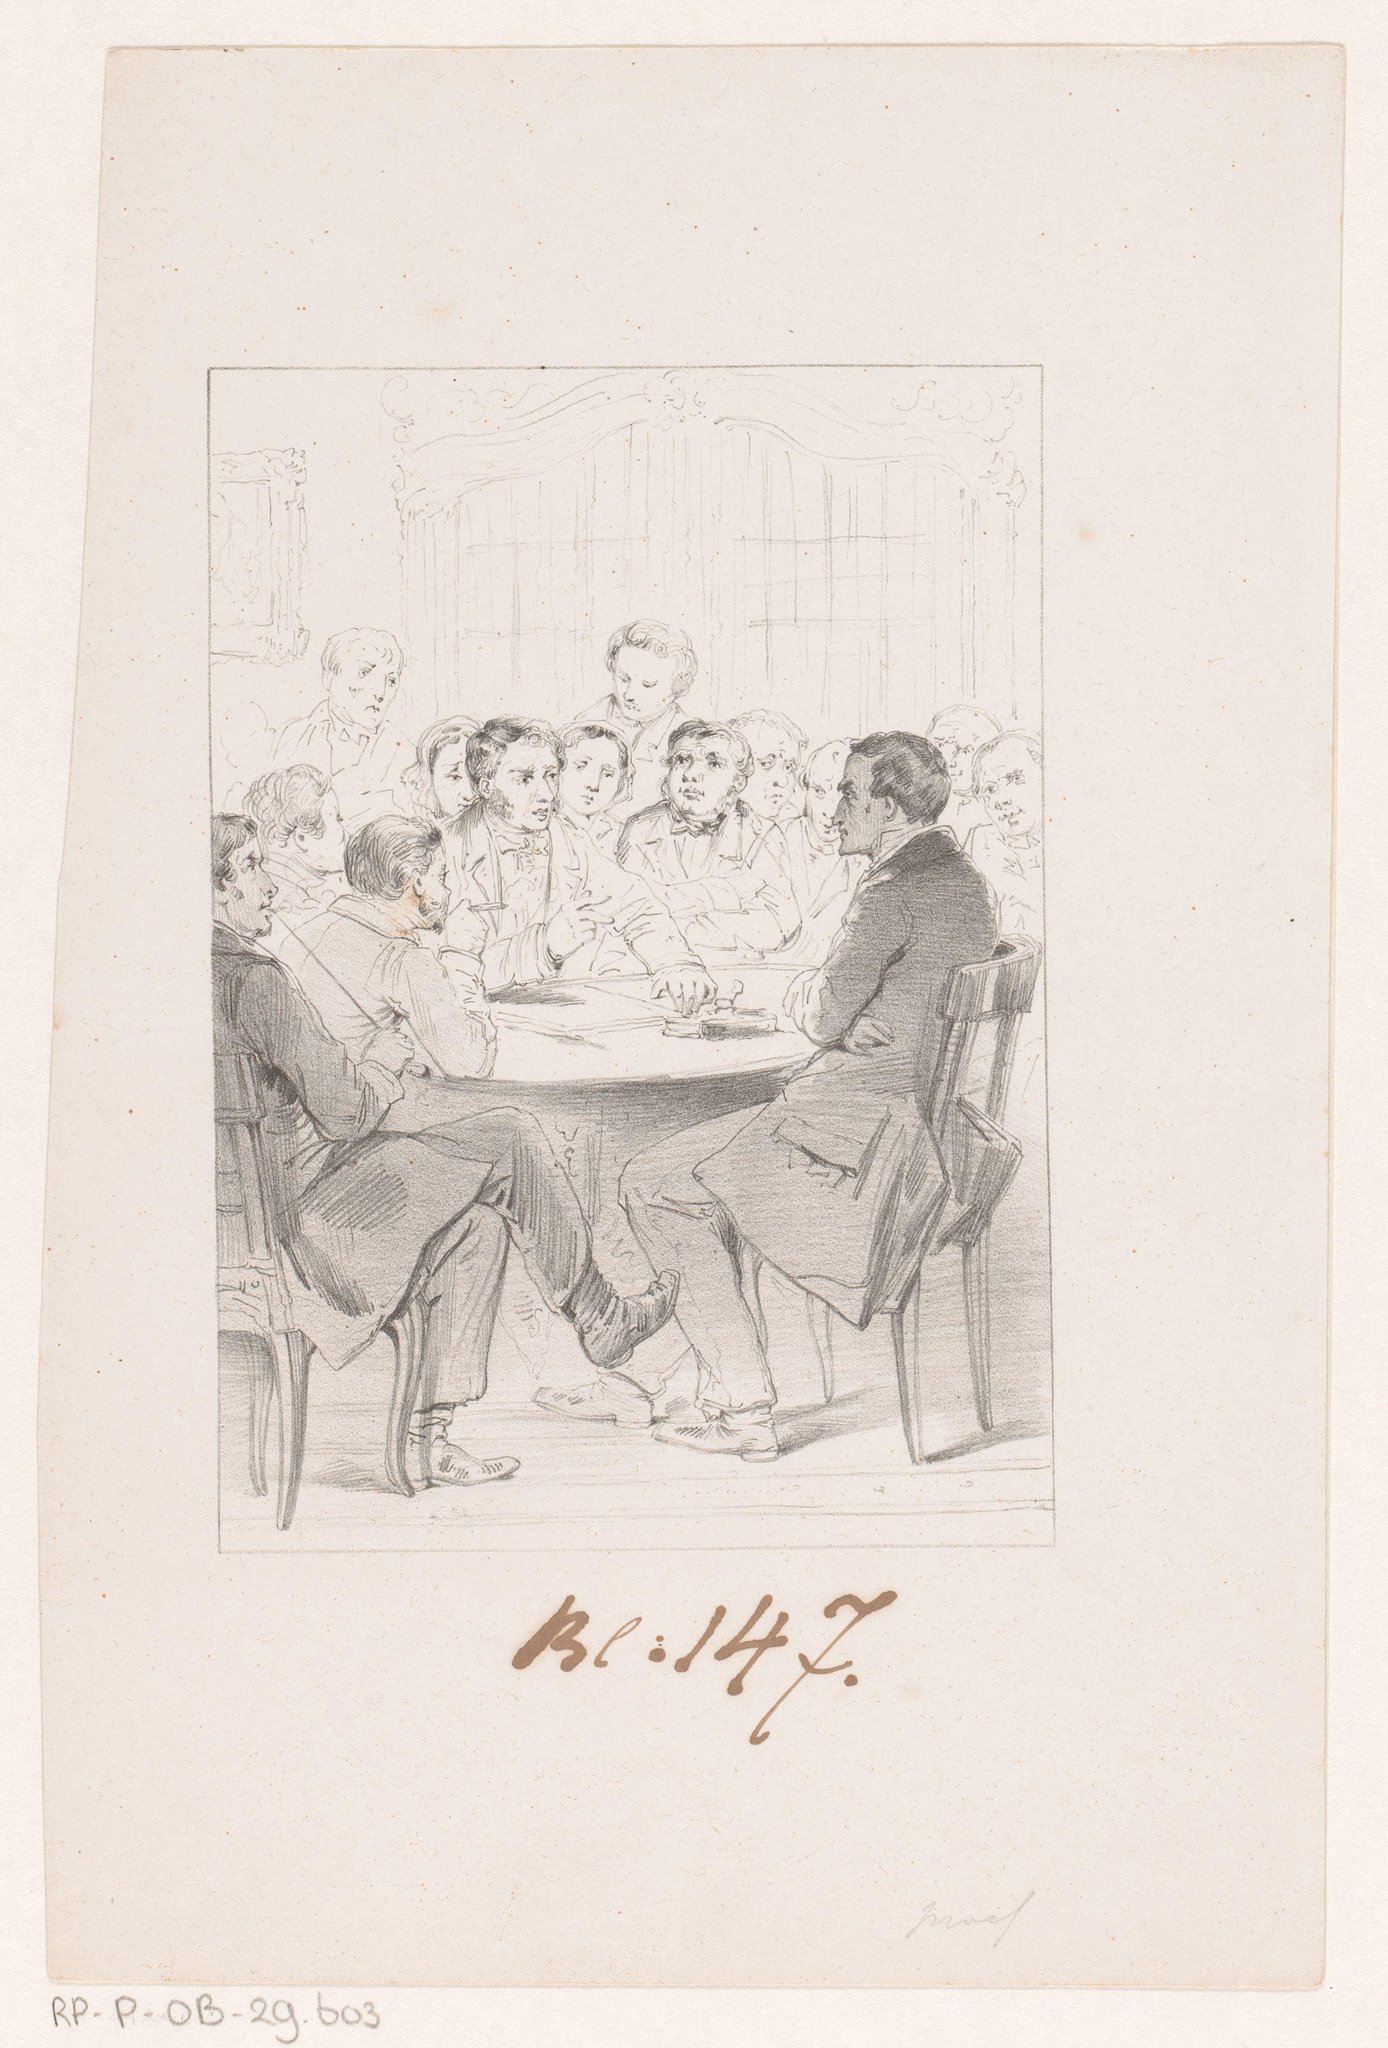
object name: print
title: Mannen rond een tafel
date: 1832-1891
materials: paper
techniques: lithograph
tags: conversation, dialogue; conversation piece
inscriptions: inscription: ‘Bl. 147’, collector's mark: Lugt 2228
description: Een groep mannen in overleg rond een tafel.